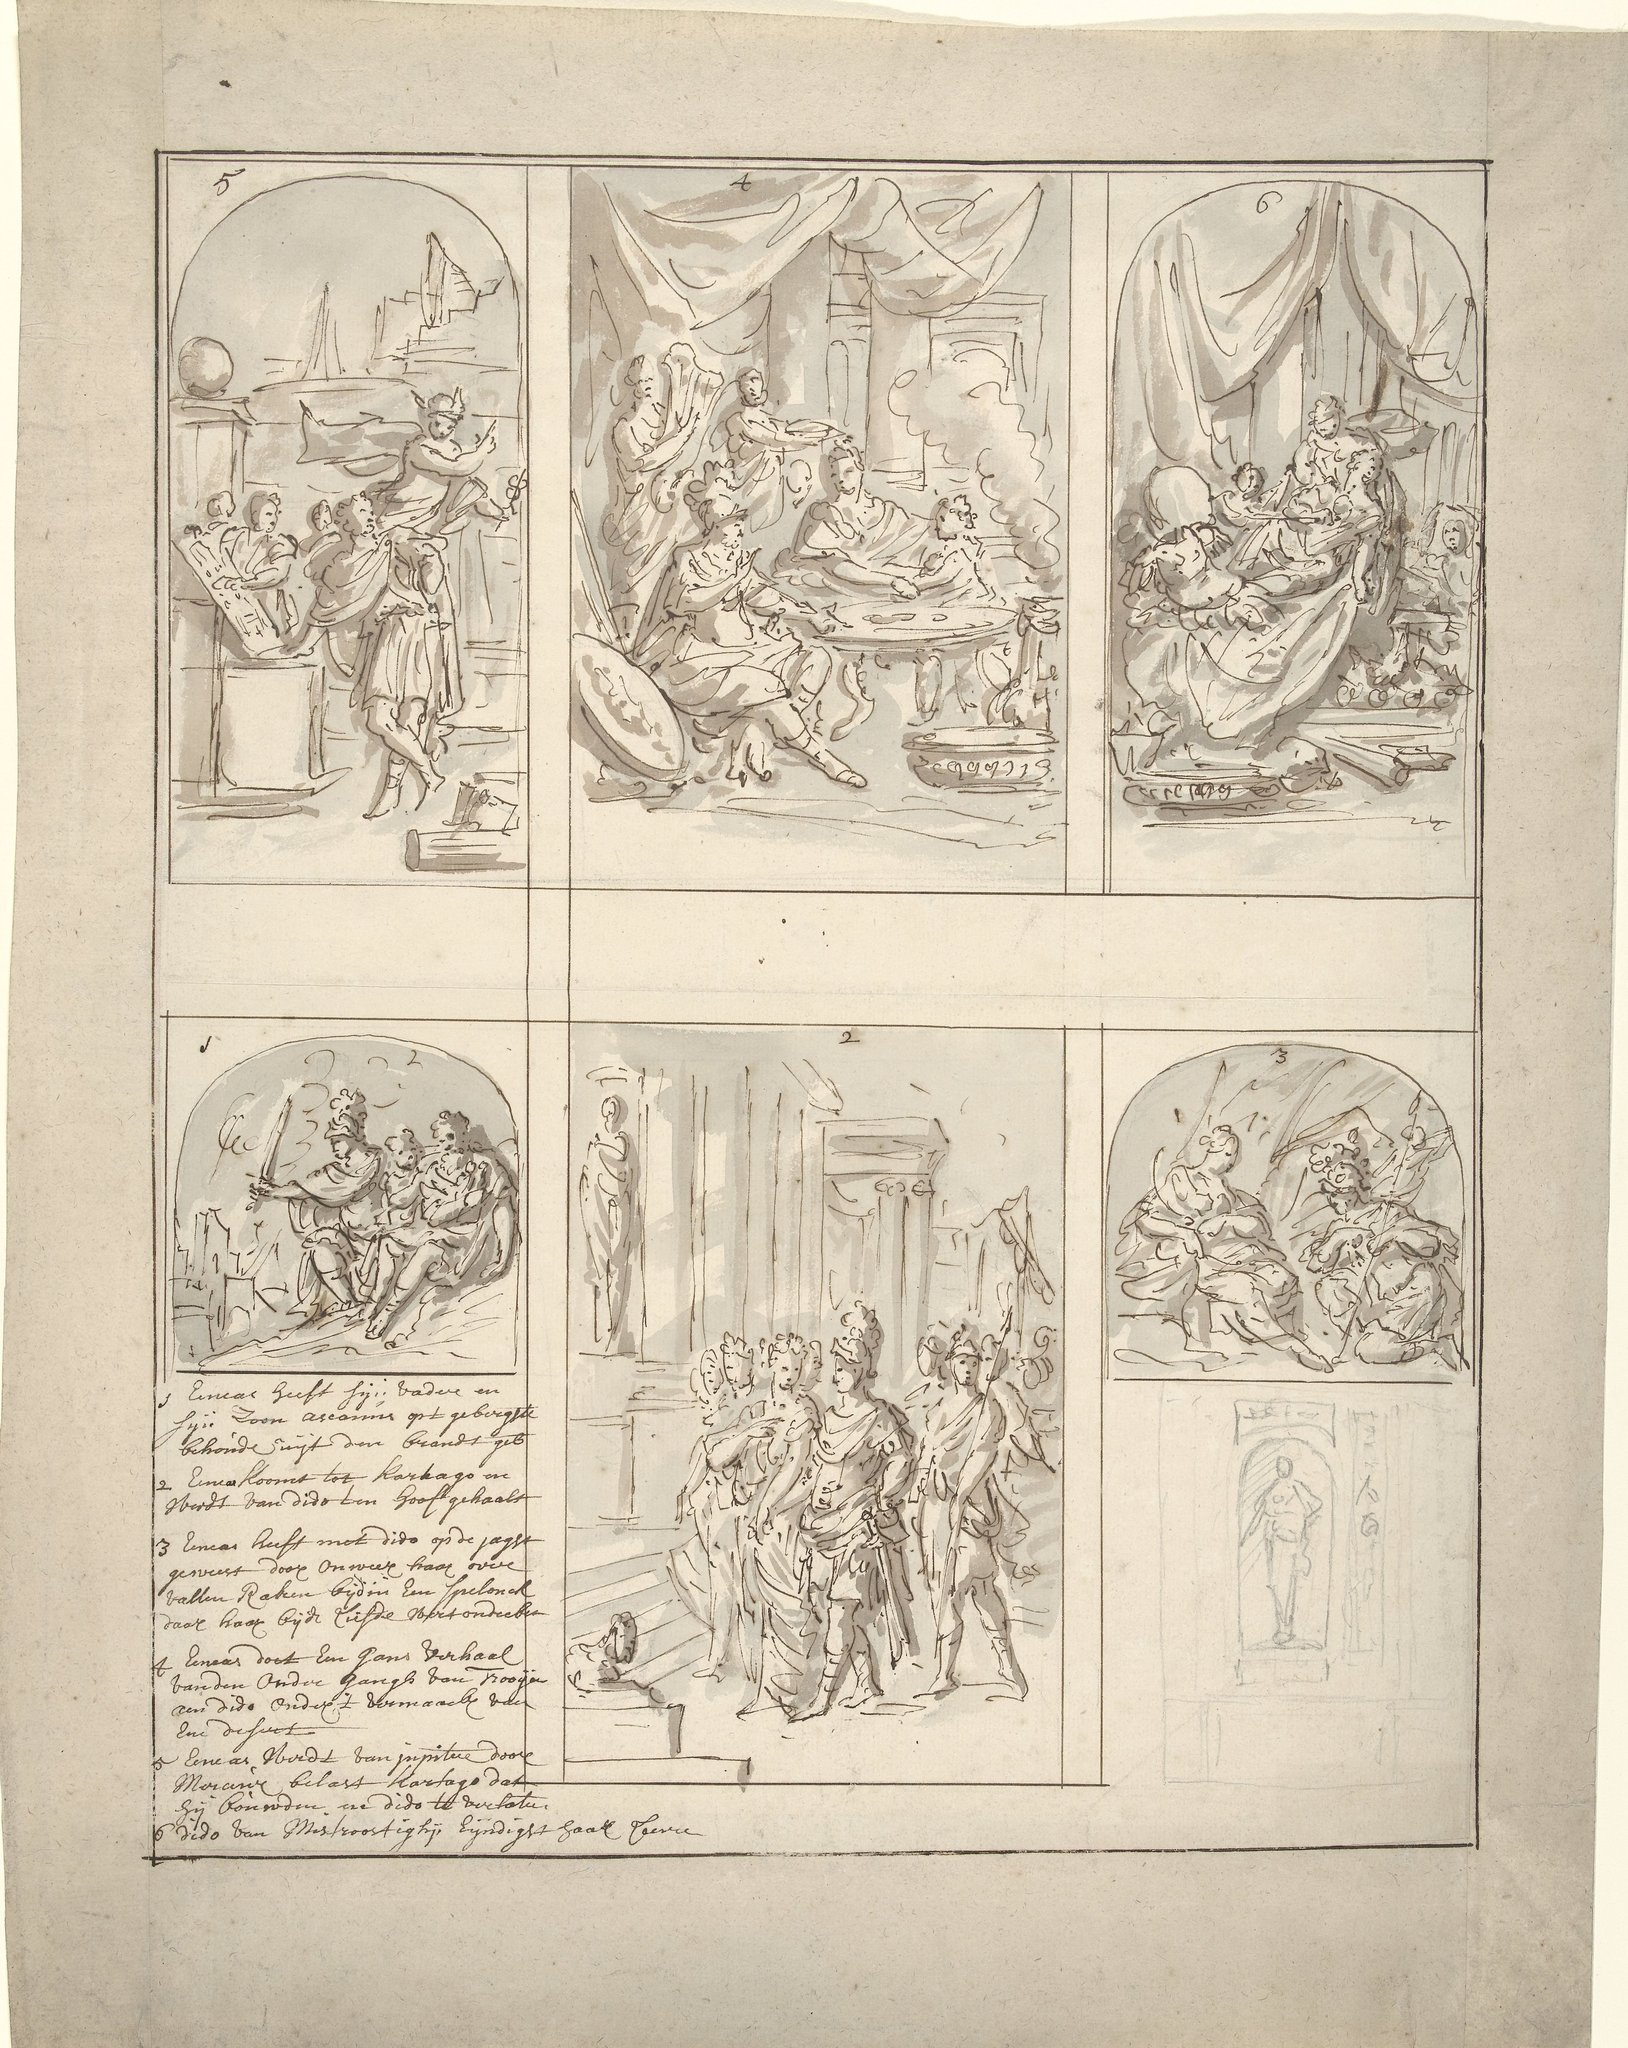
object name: drawing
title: Ontwerp voor een kamerbeschildering met scènes uit het leven van Aeneas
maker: elias van nijmegen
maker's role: draughtsman, painter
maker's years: 1667-1755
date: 1677-1755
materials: ink, paper, pencil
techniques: brush, pen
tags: the story of aeneas' wanderings to italy (virgil, aeneid)